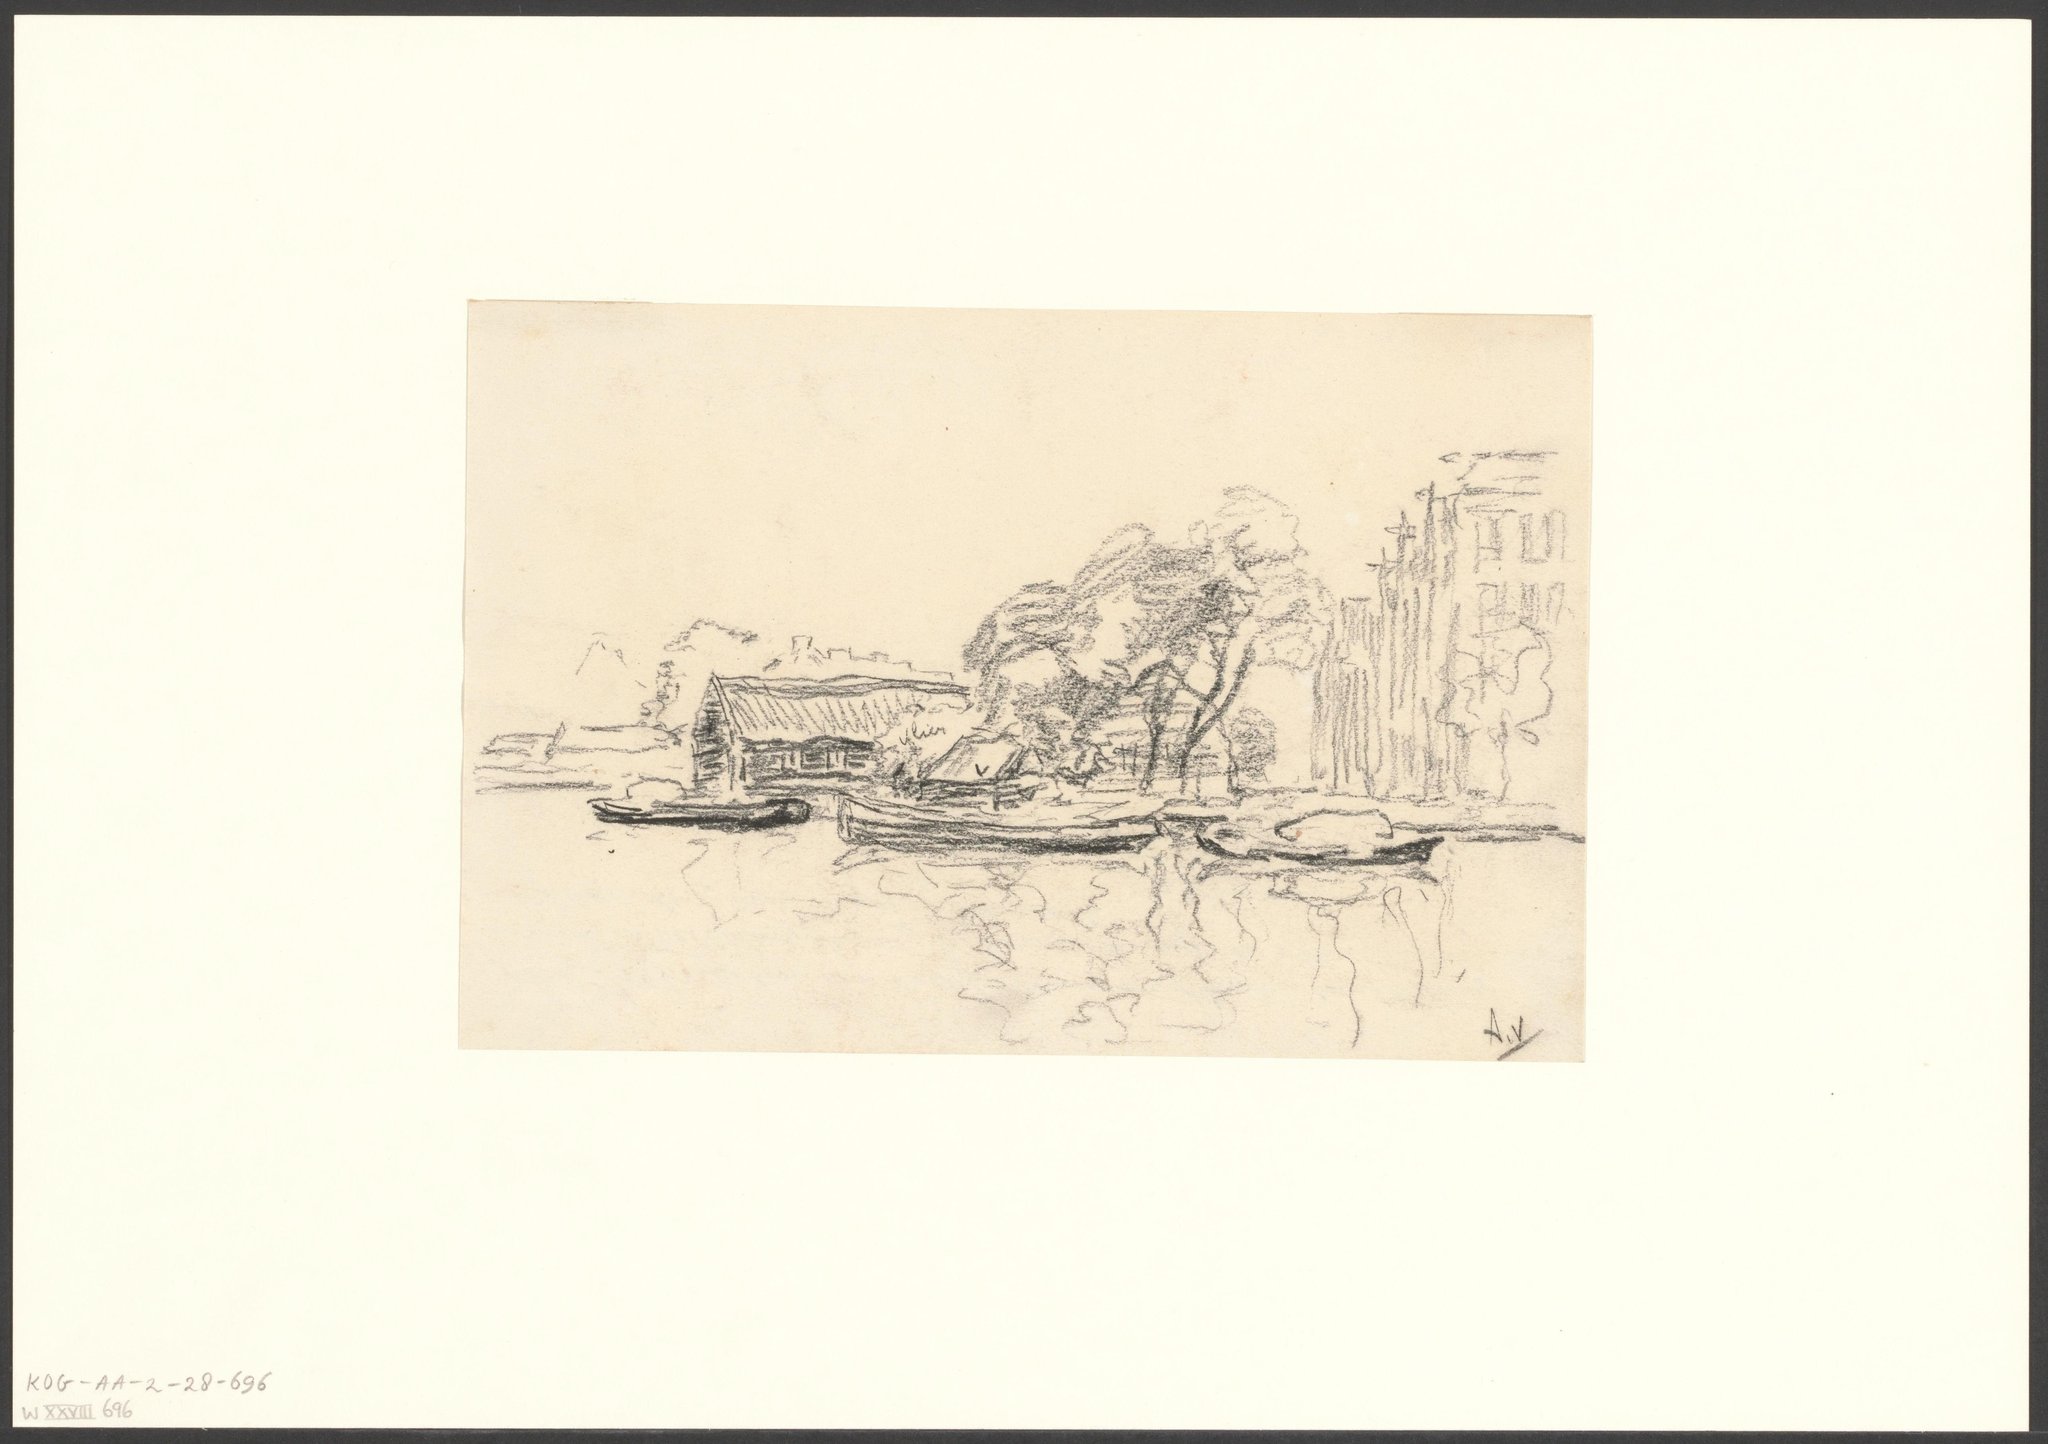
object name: drawing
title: Gezicht op de scheepstimmerwerf aan de Kostverlorenvaart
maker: anthonie van teijn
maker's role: draughtsman, painter, print maker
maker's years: 1863-1943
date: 1907-1927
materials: chalk, paper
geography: amsterdam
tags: city-view in general; 'veduta', canal, boat propelled by man or animal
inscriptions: signature: ‘A.v’, collector's mark: Lugt 800a, inscription: ‘Scheepstimmerwerf aan de (...) Juli 1927 / vanEck’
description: Tekening binnen de Atlas Van Eck ingedeeld op wijknummer 28.